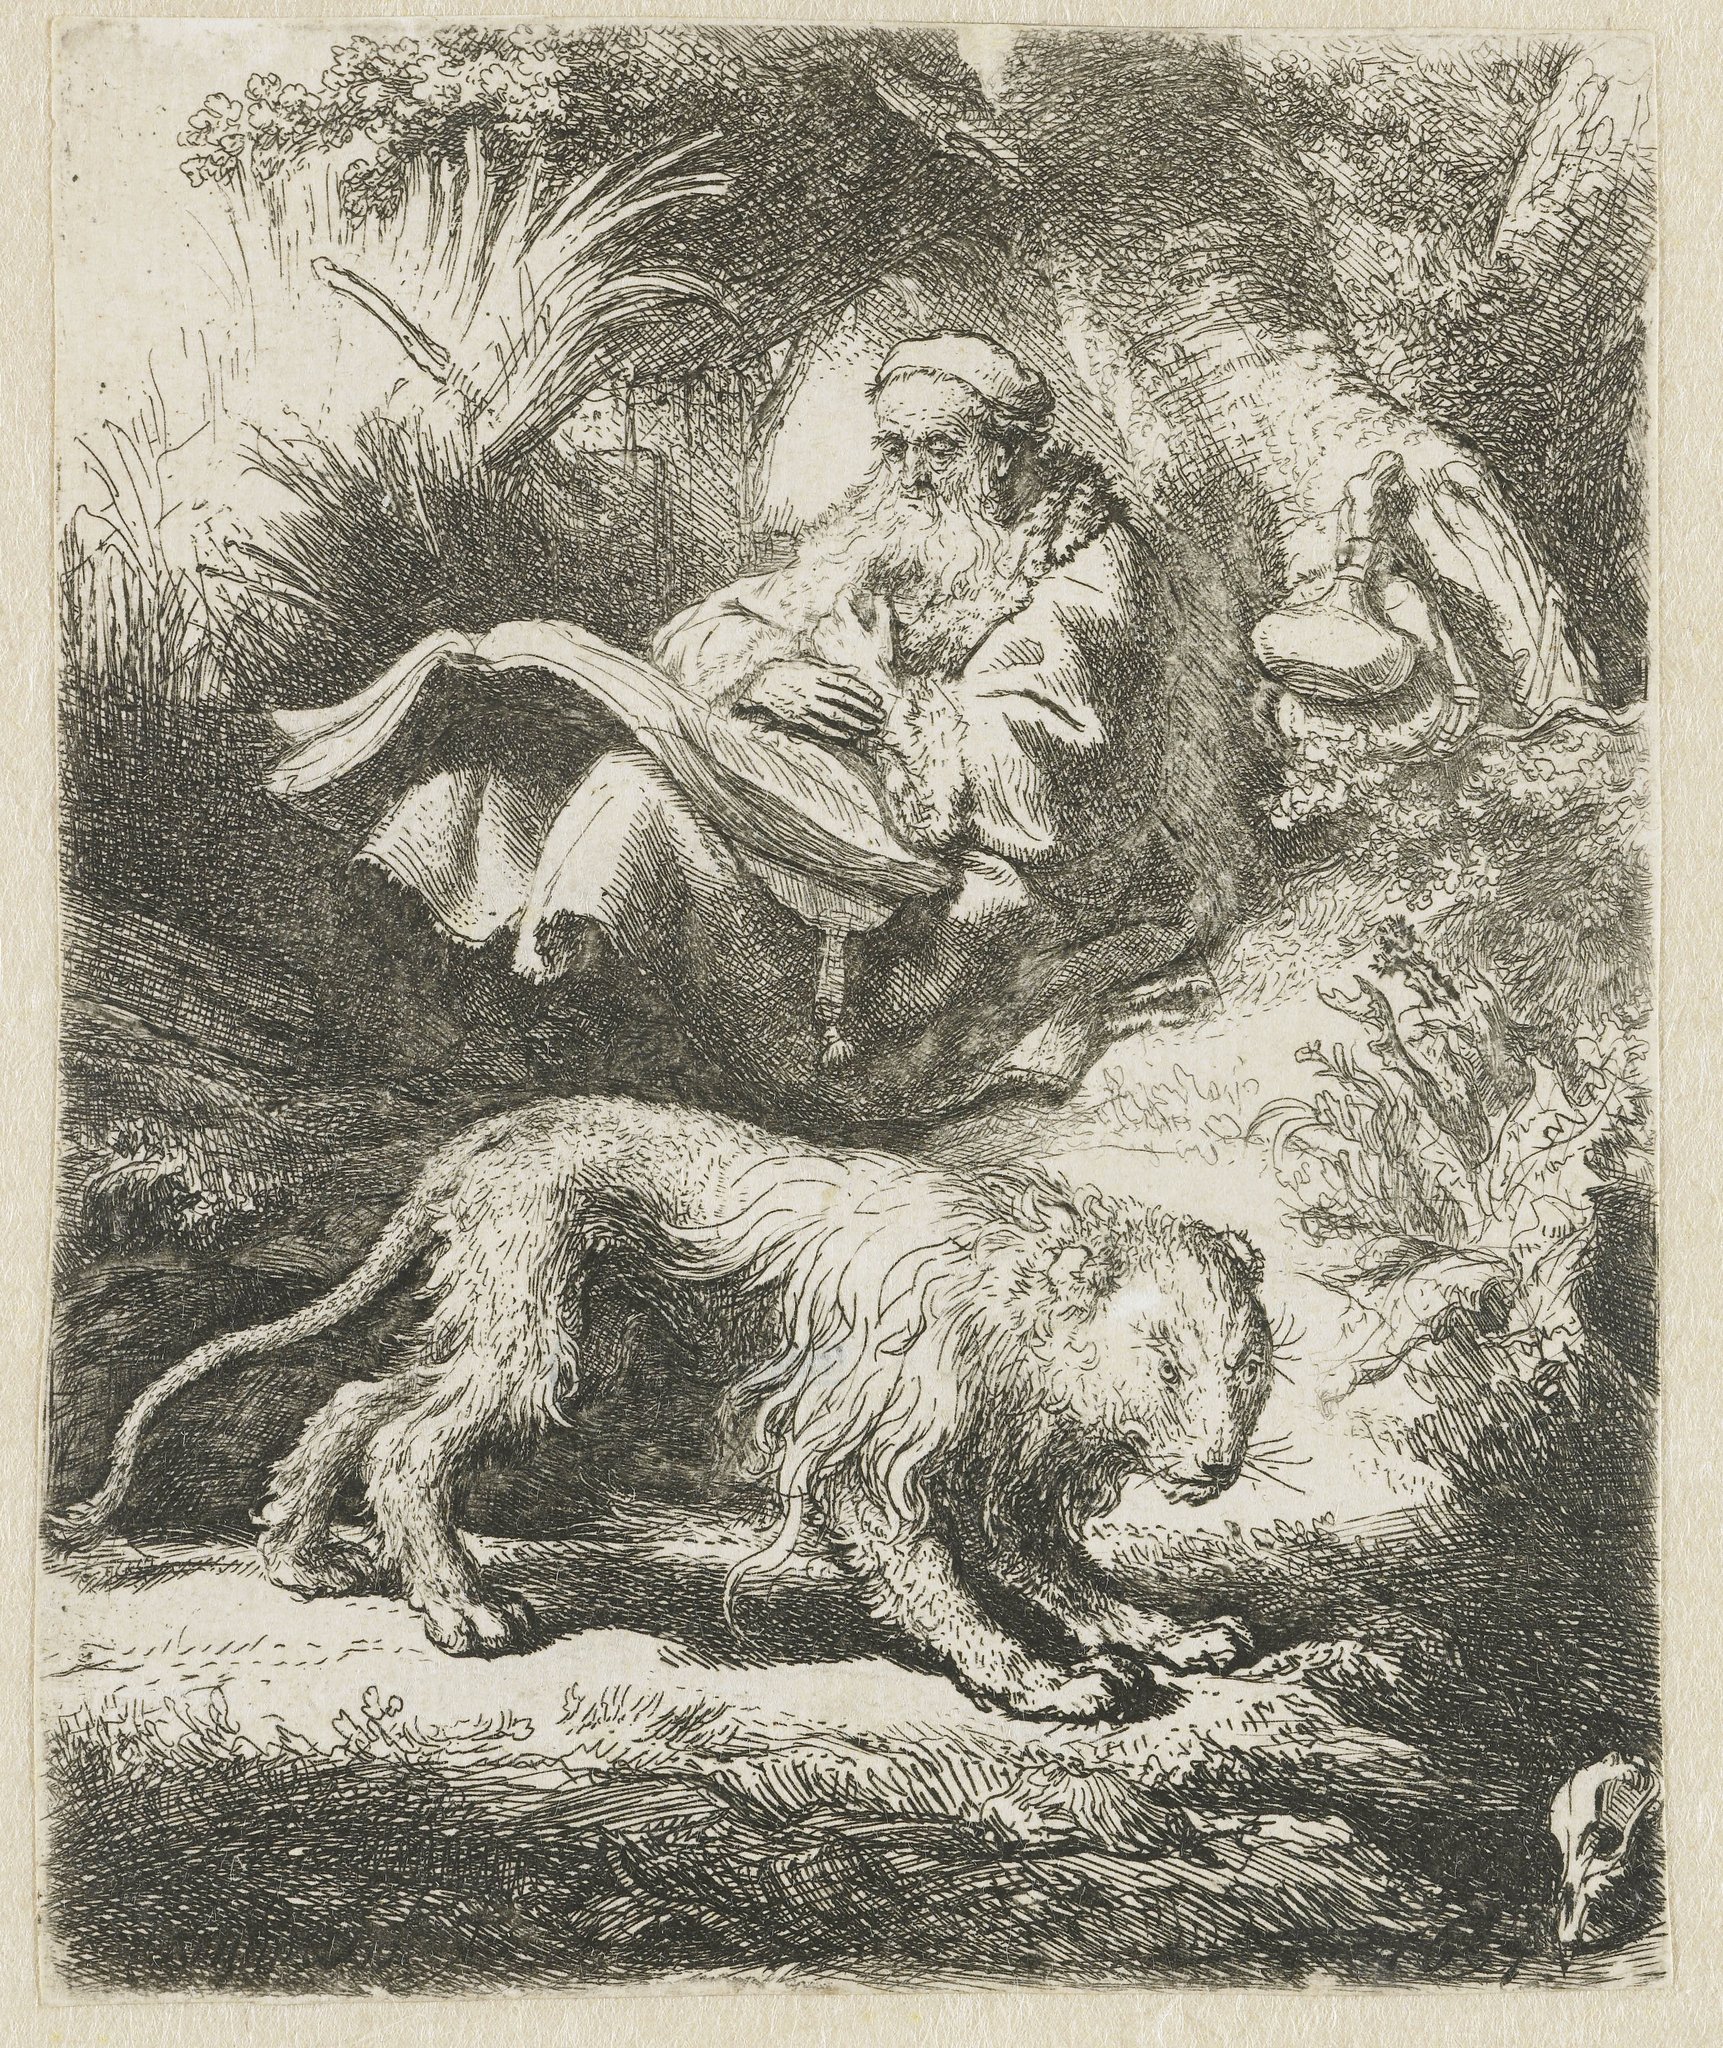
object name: print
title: St Jerome reading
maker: rembrandt van rijn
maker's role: draughtsman, painter, print maker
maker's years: 1606-1669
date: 1634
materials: paper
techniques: etching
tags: st. jerome as hermit in a landscape, reading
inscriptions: signature: ‘Rembrandt f.’, date: ‘1634’, mark: Lugt 2228 a, mark: ‘CdE Geneve (in een cirkel) doublet’